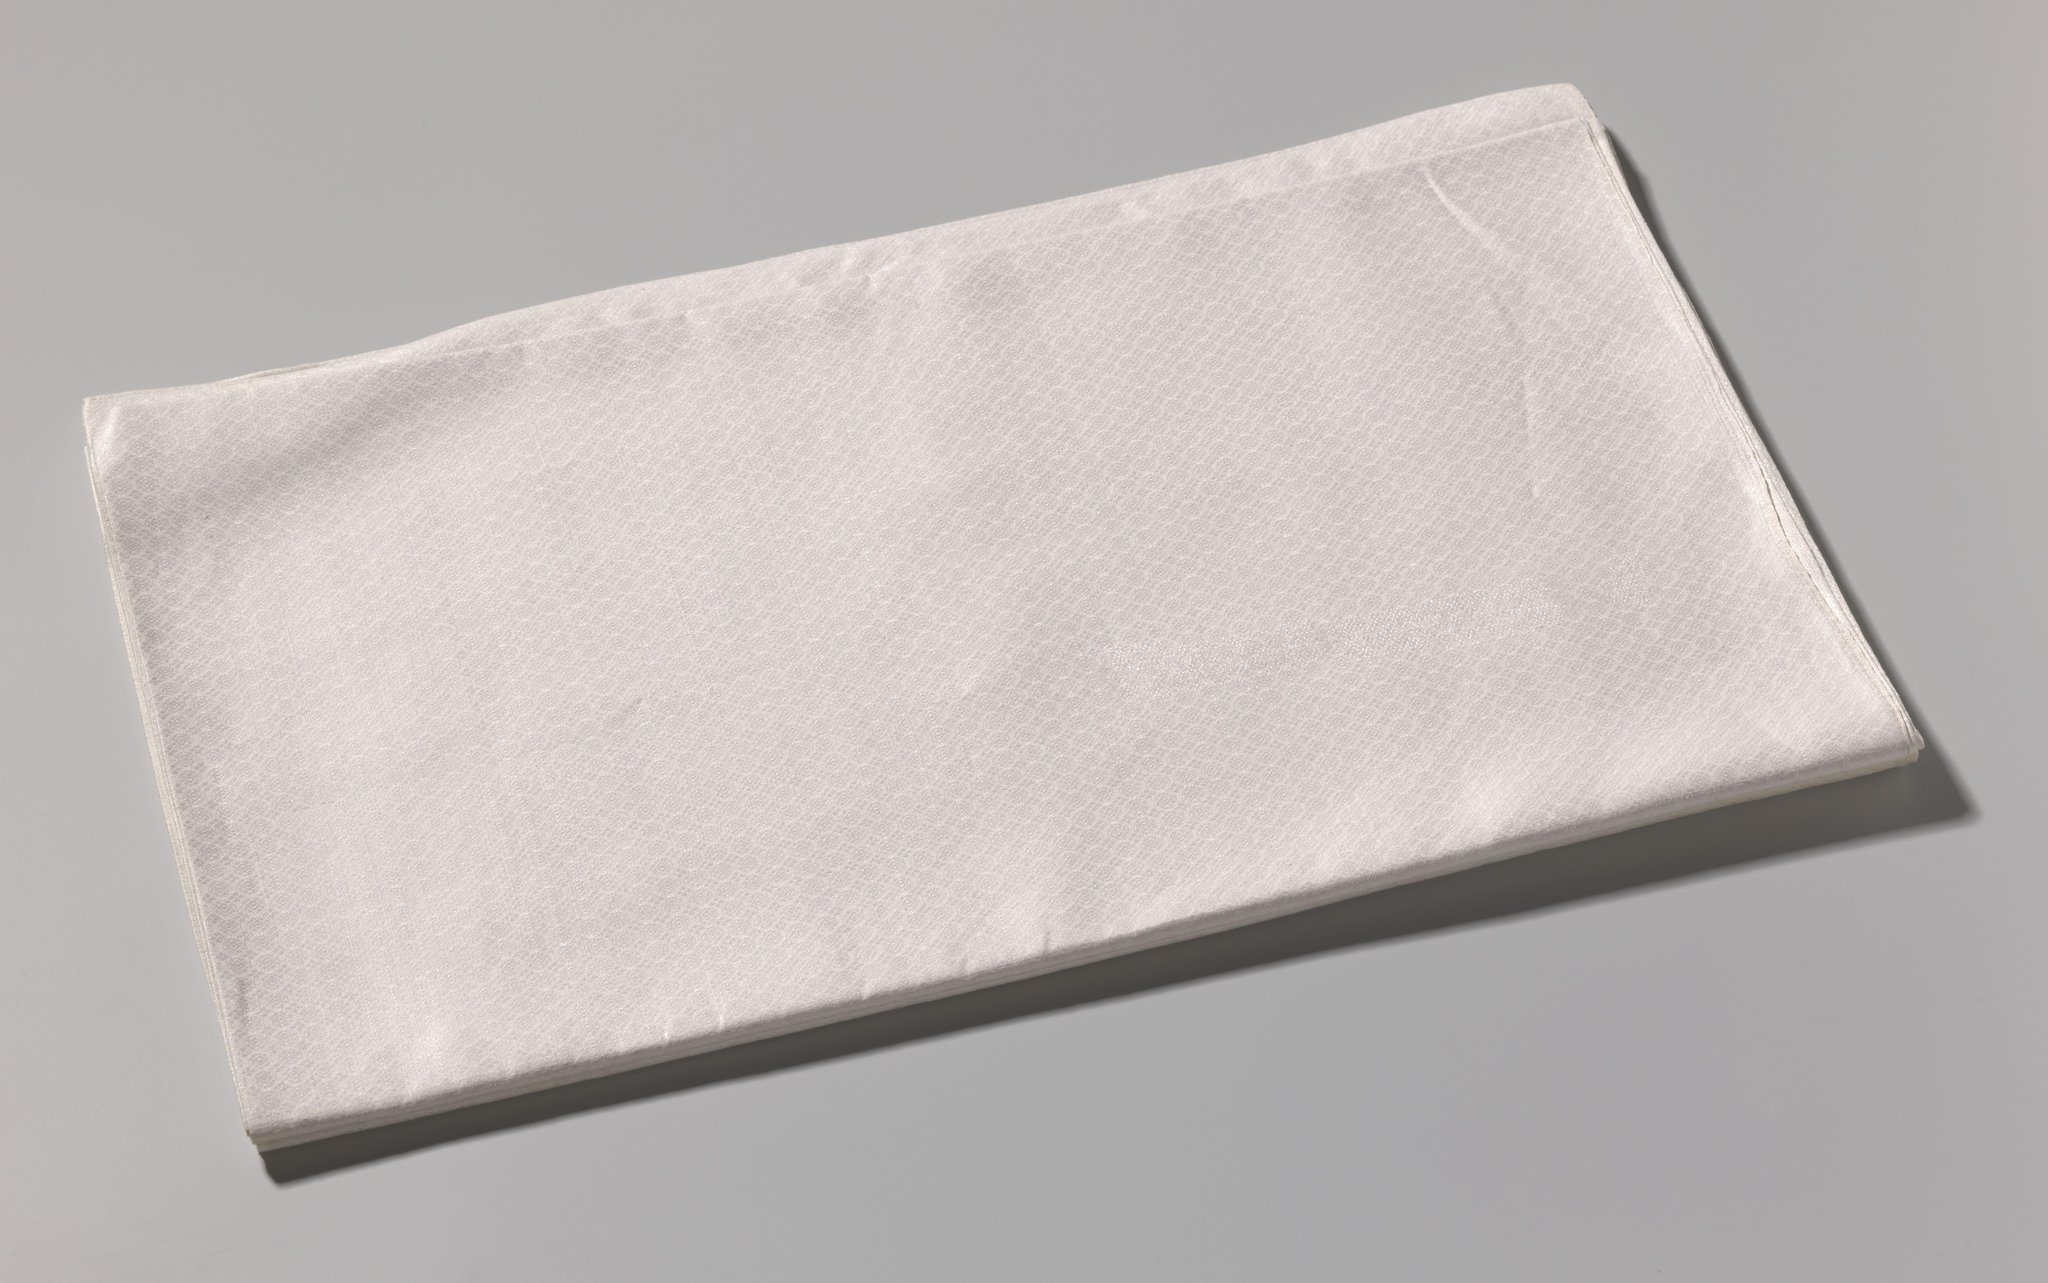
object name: tablecloth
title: Tafellaken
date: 1640-1660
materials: linen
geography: northern netherlands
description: Wit linnen tafellaken met "lavendel"-patroon. Merk HW 1.